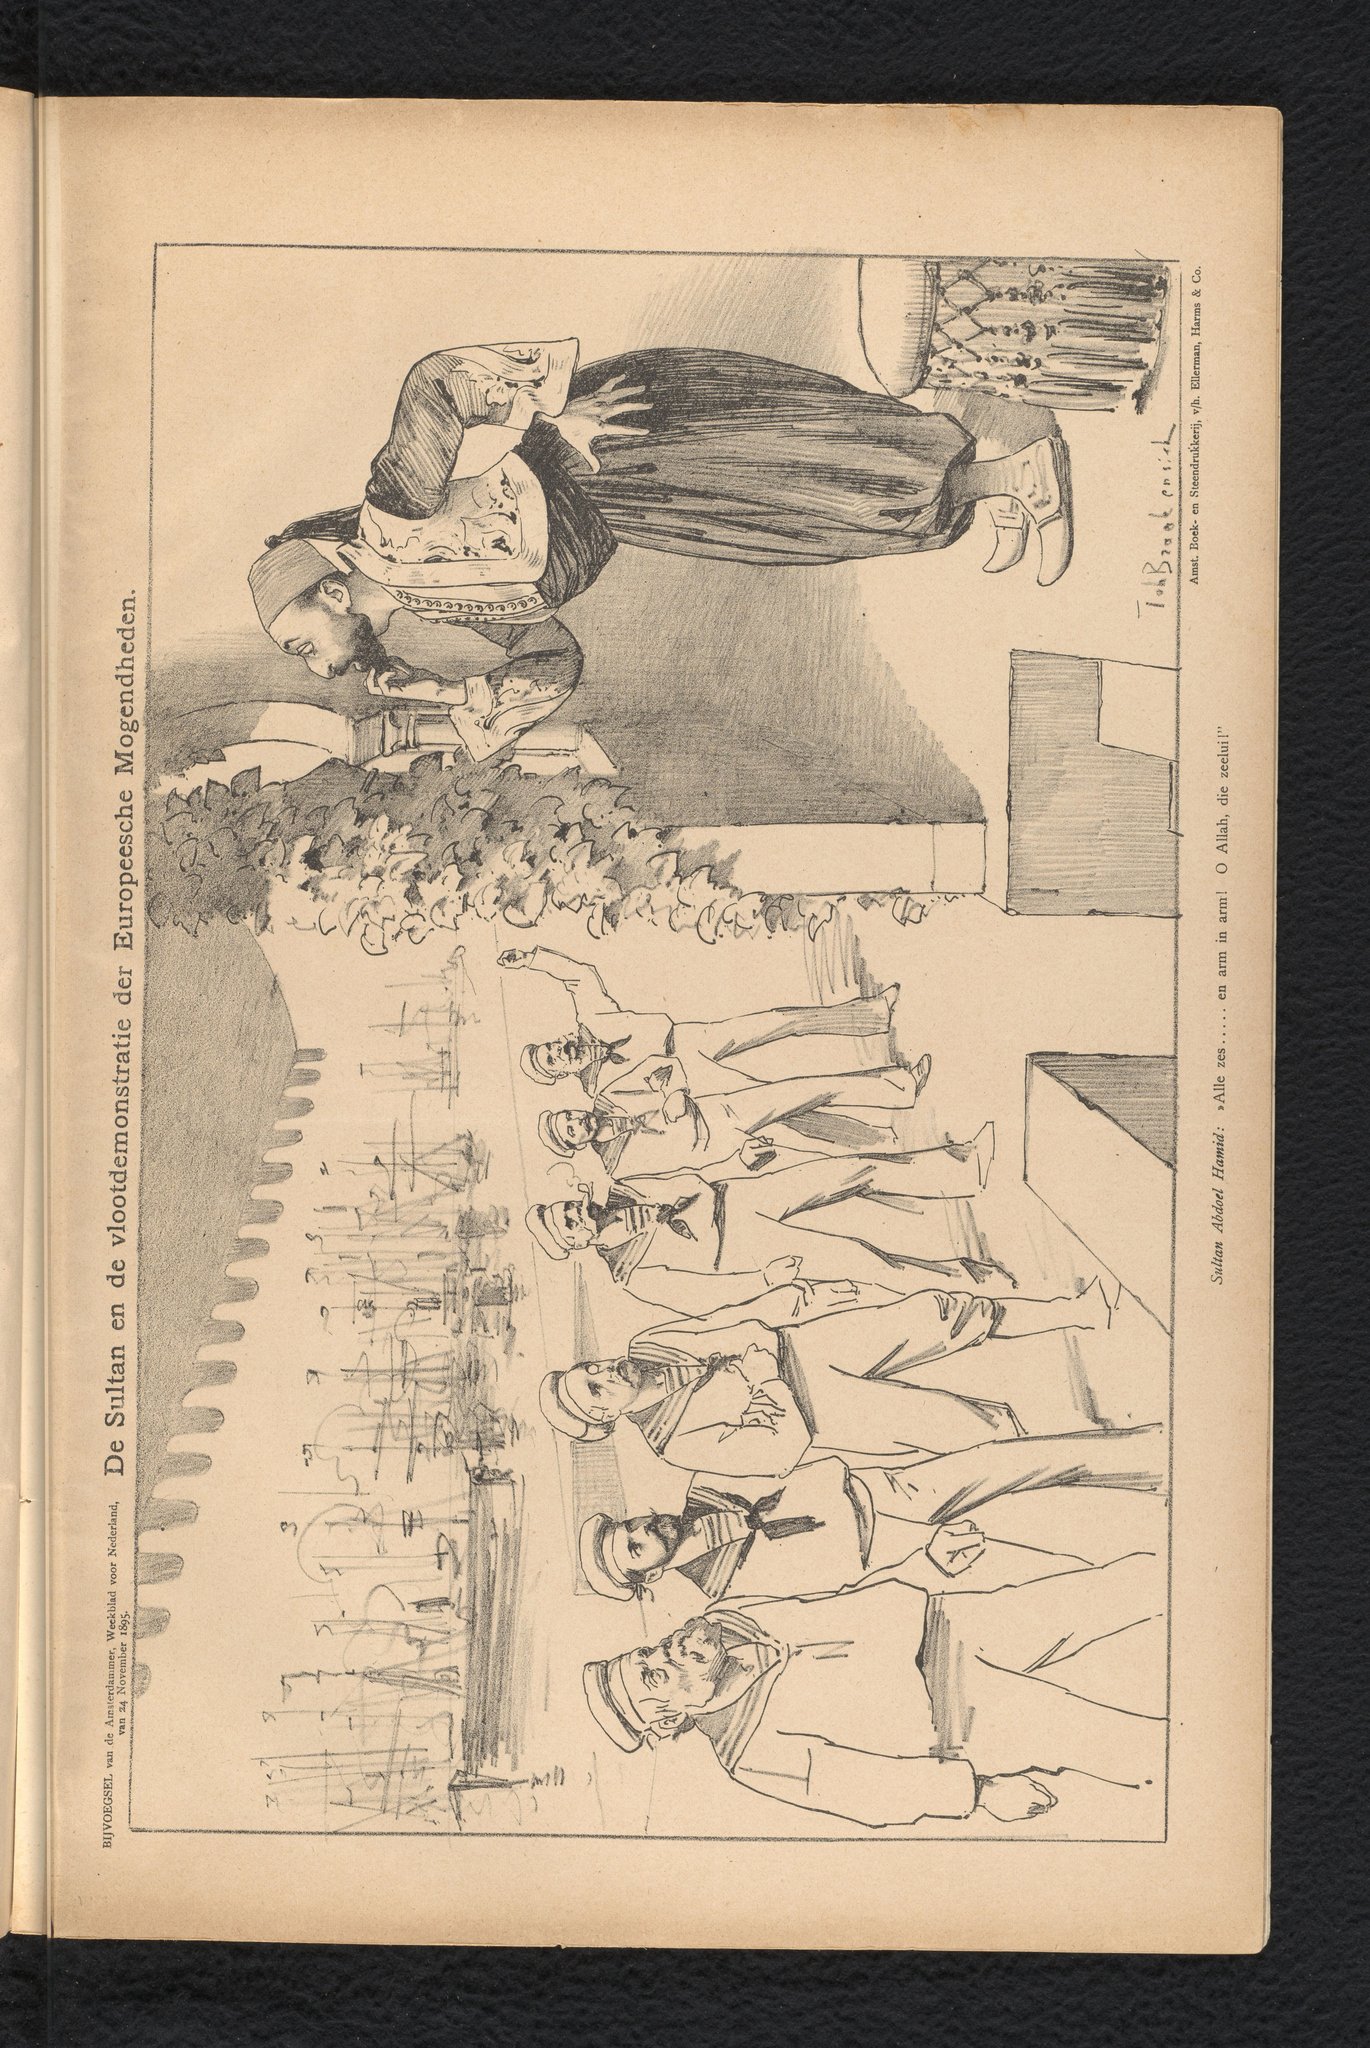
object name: cartoon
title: De Sultan en de vlootdemonstratie der Europeesche Mogendheden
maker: johan braakensiek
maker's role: draughtsman, print maker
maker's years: 1858-1940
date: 1895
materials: paper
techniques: lithograph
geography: netherlands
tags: navy, political caricatures and satires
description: De leiders van de Europese mogendheden als matrozen arm in arm tegenover een verbaasd kijkende Turkse sultan.